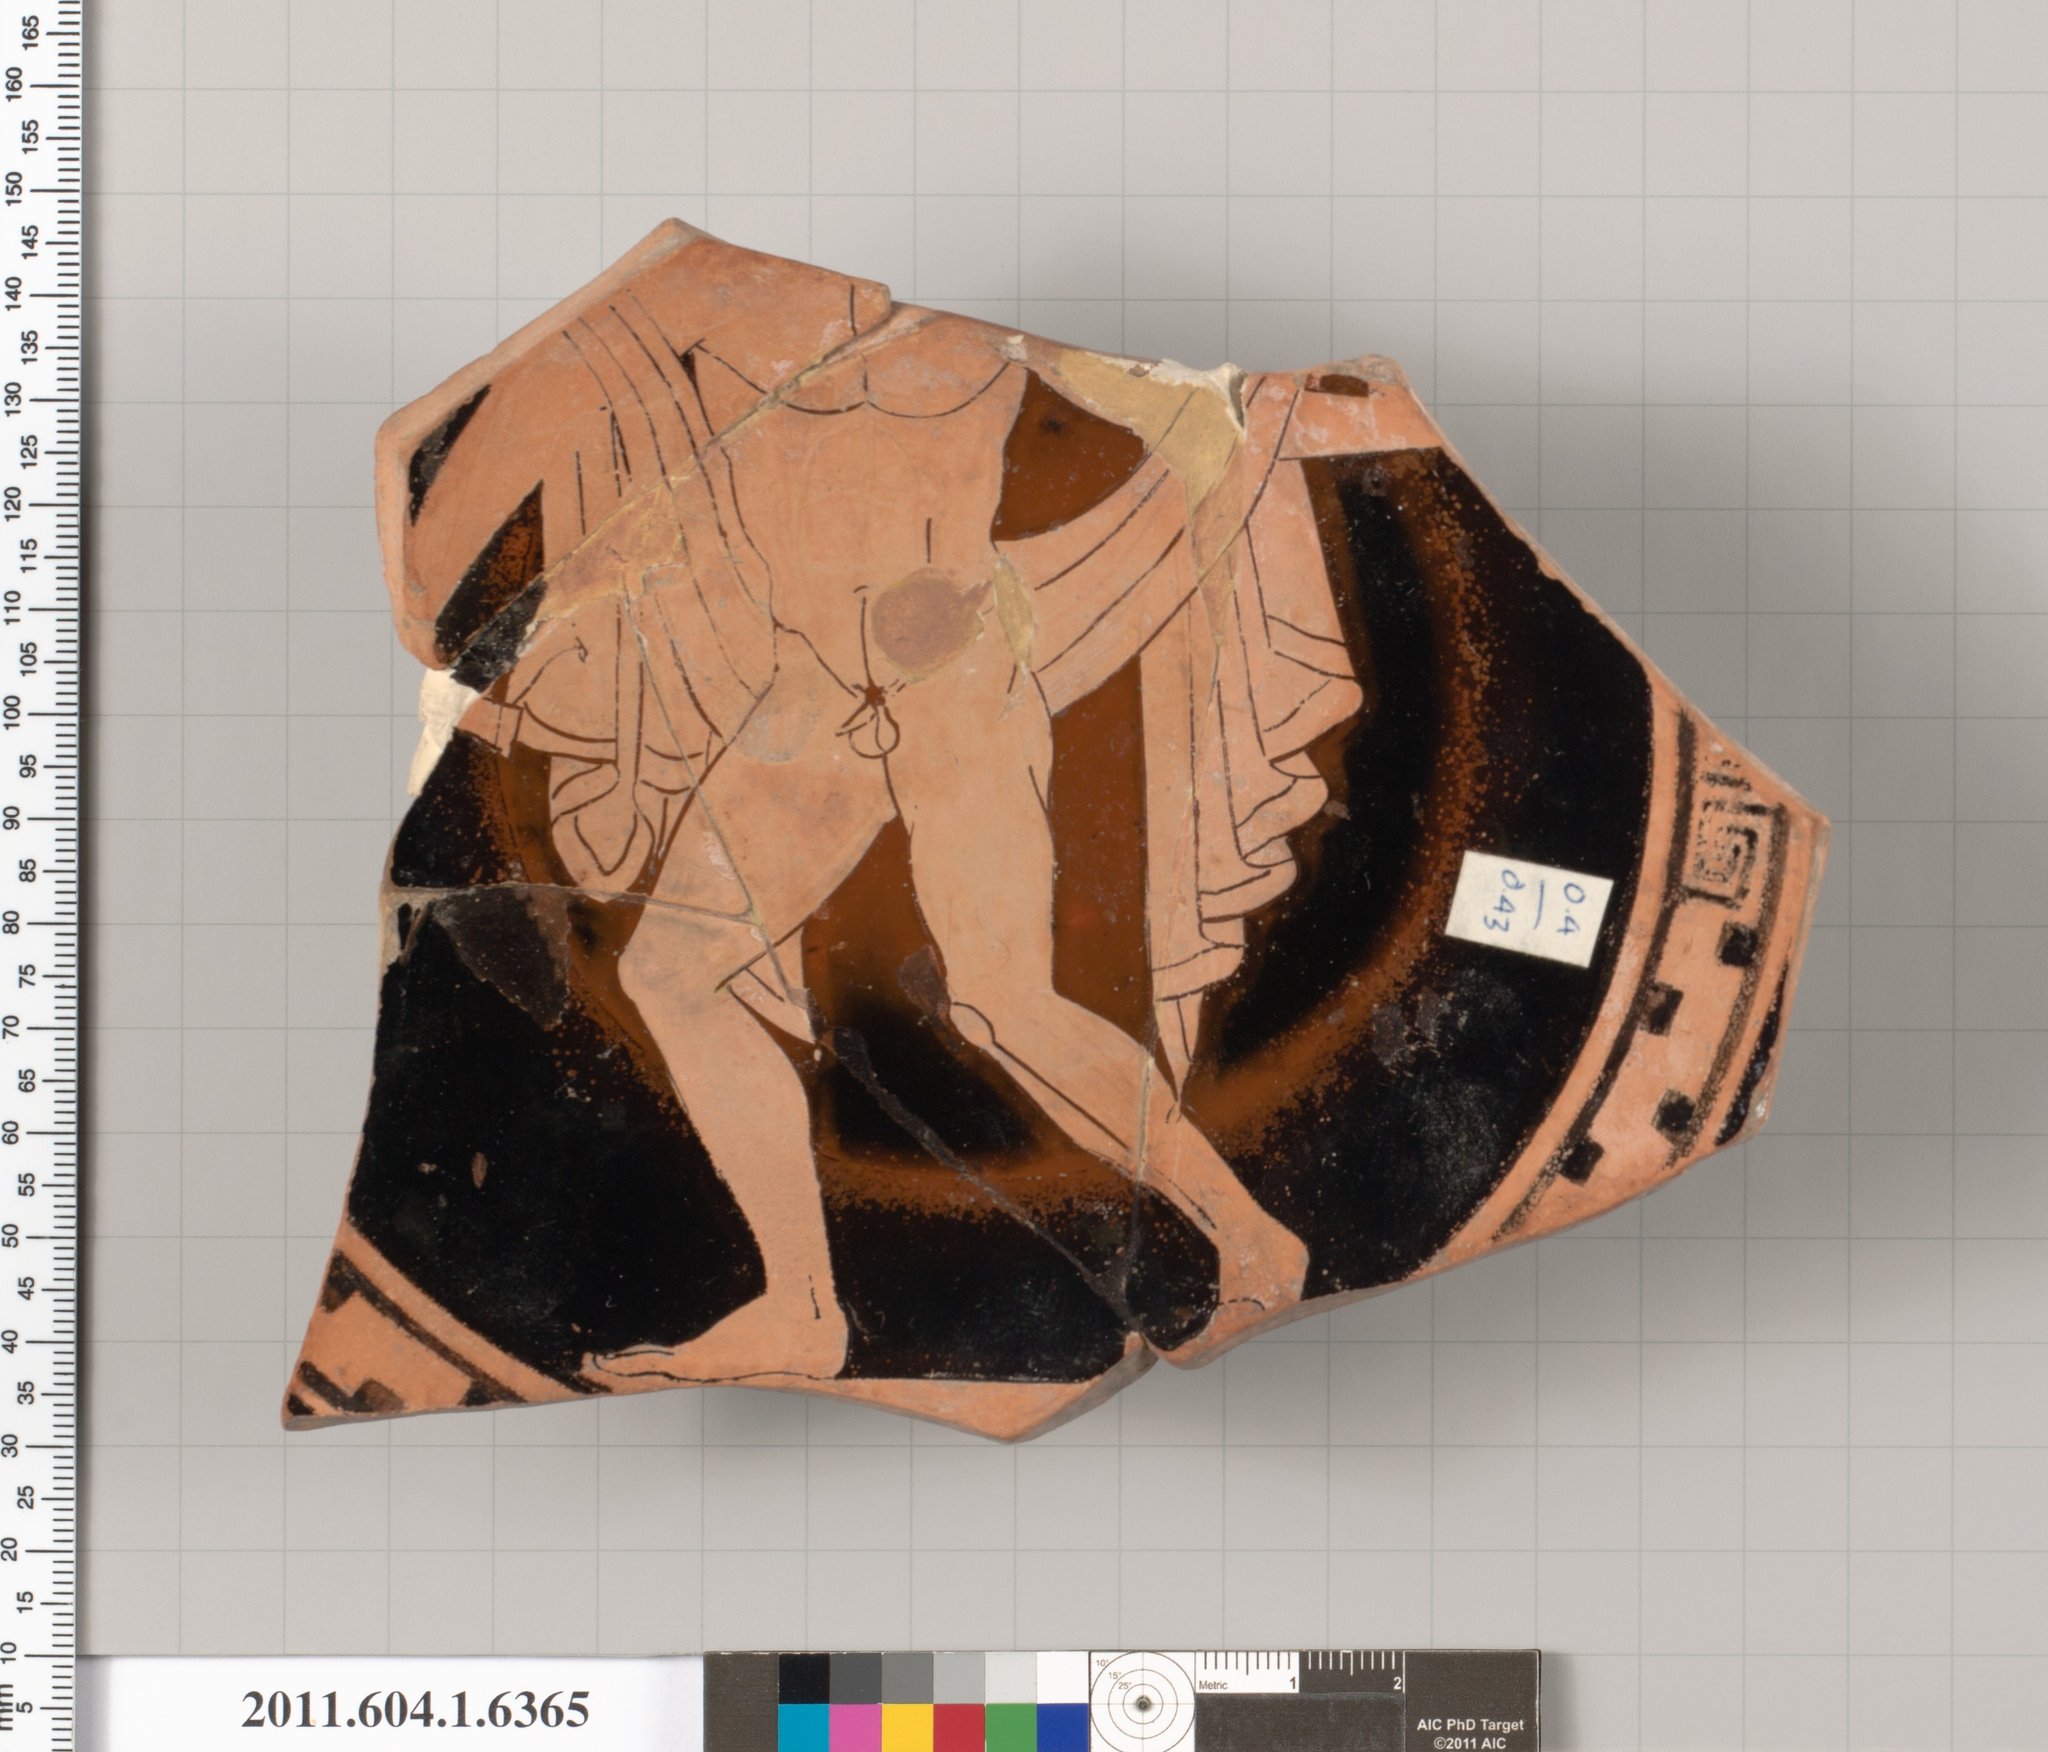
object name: kylix fragment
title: Terracotta fragment of a kylix (drinking cup)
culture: greek, attic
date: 490-480 BCE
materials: terracotta